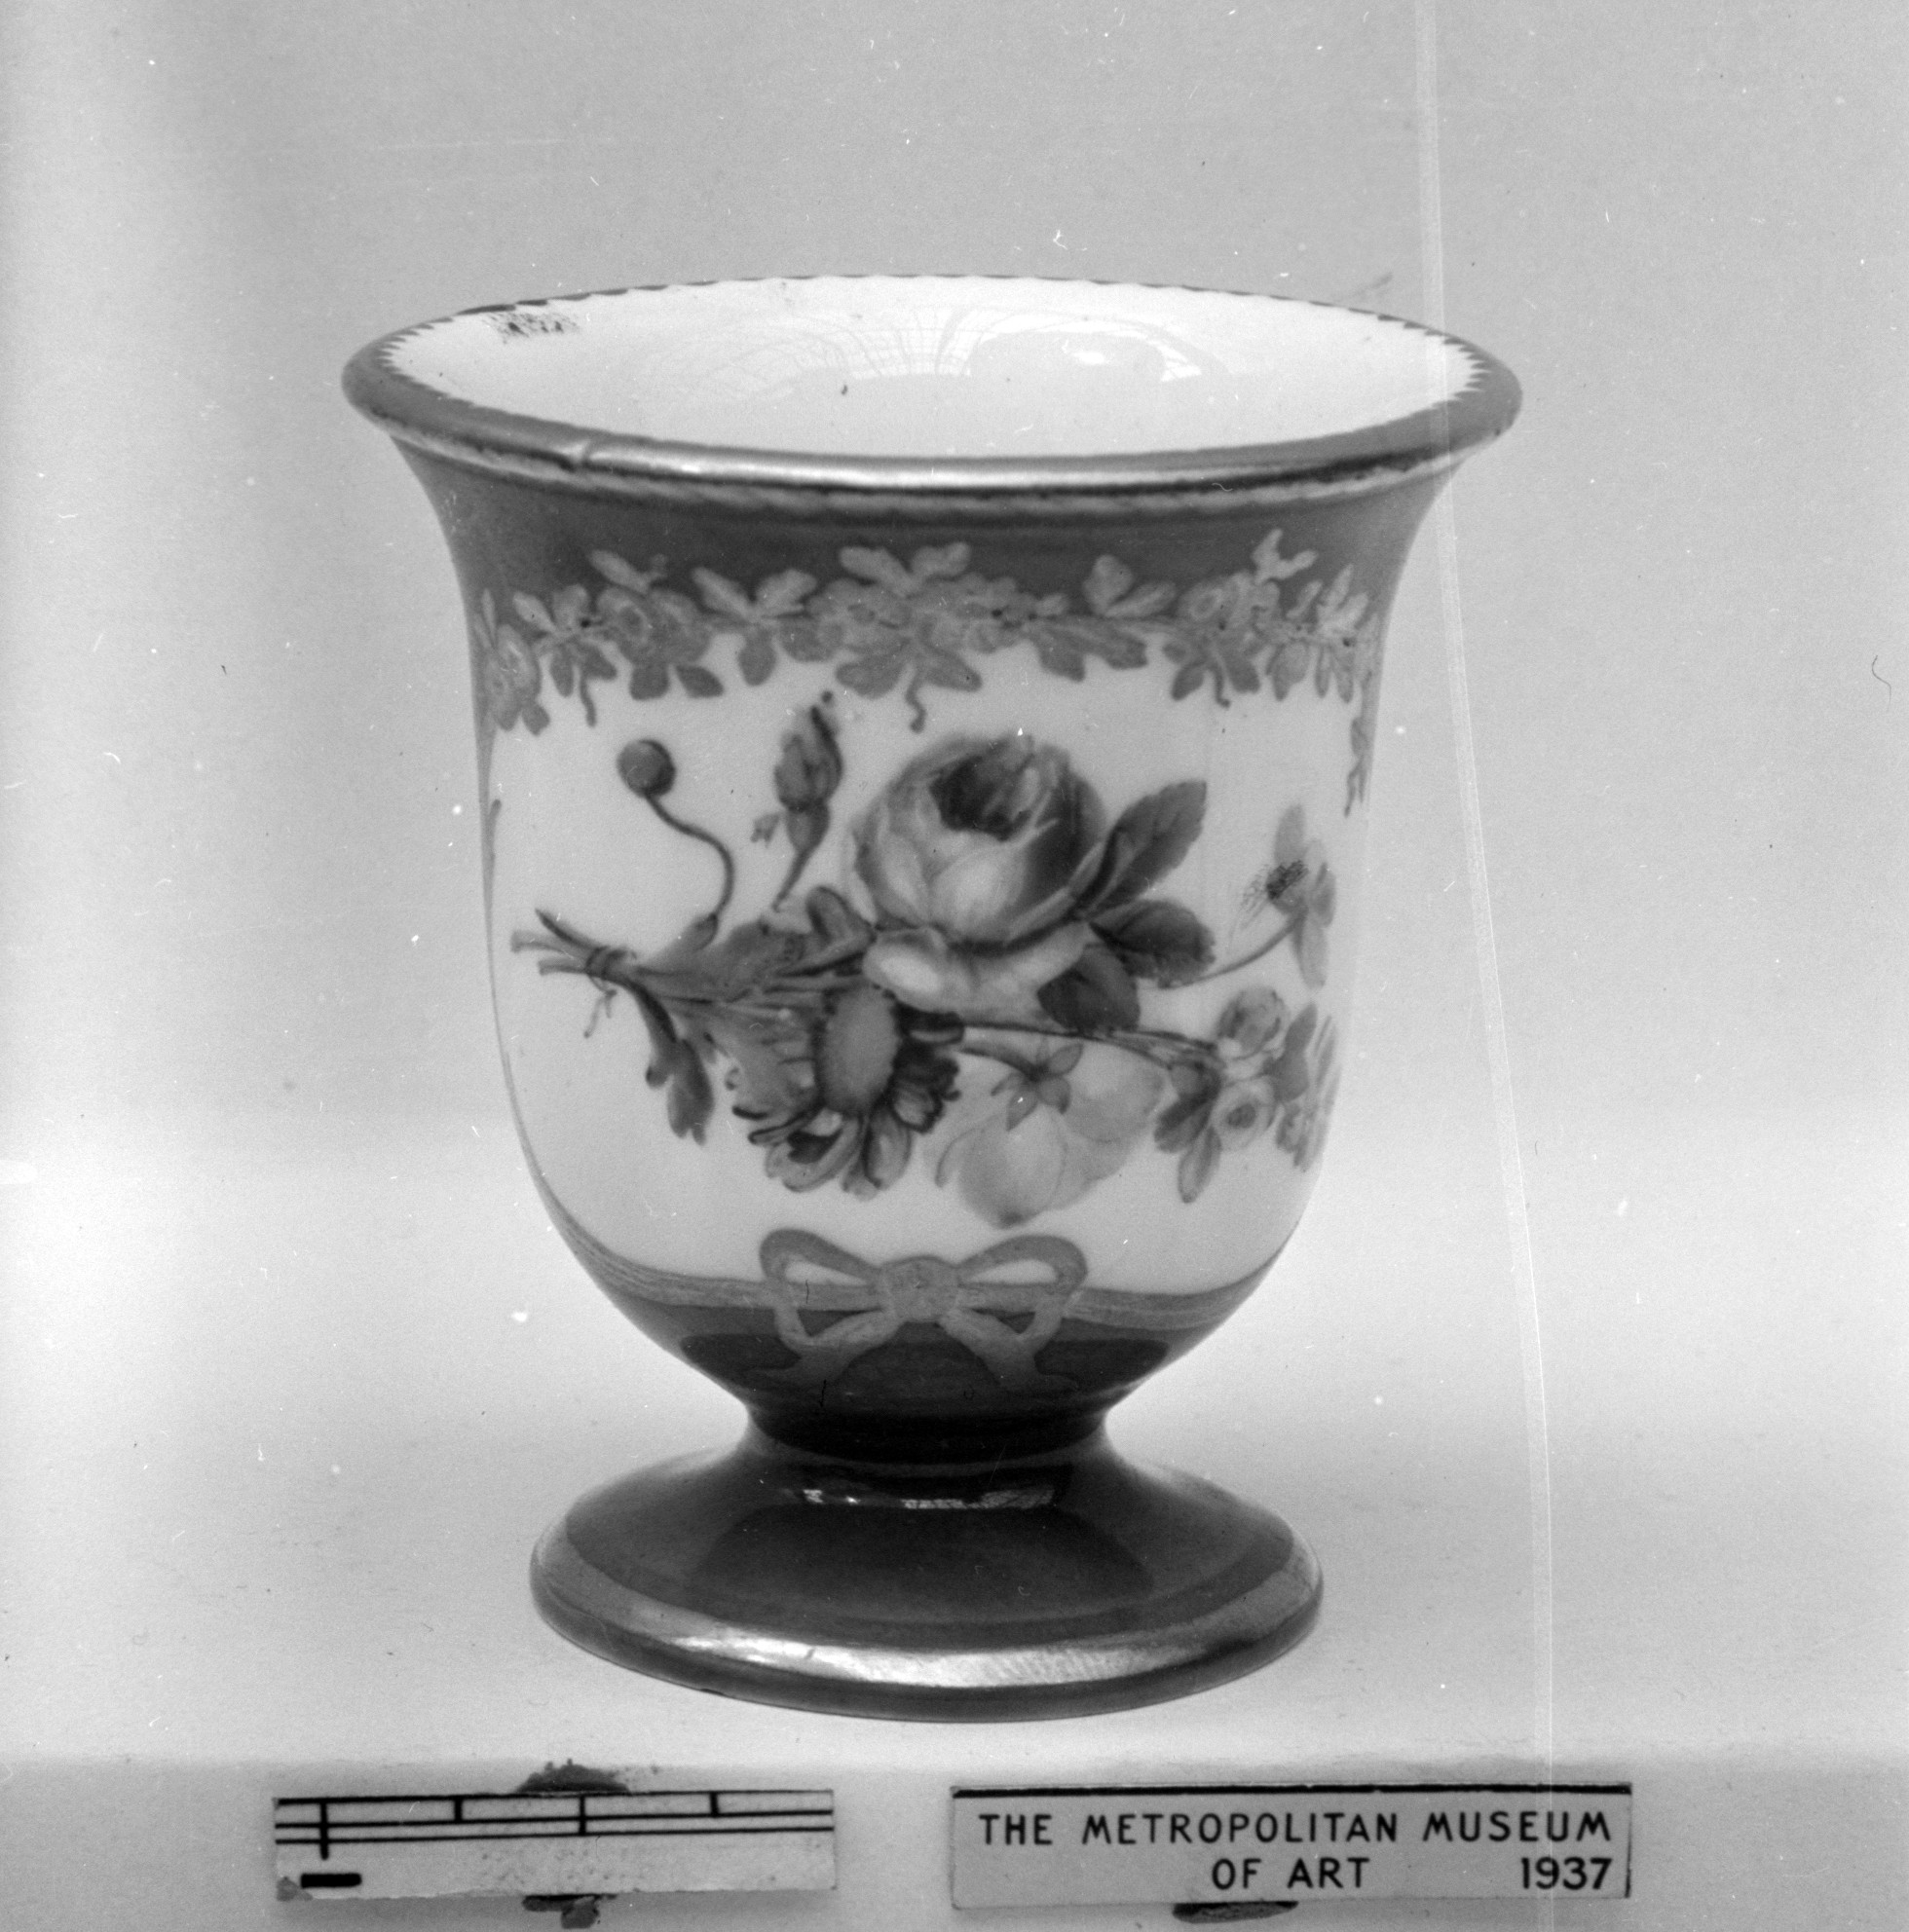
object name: ice cream cup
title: Ice cream cup (Tasse à glace) (part of a service)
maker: sèvres manufactory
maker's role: manufactory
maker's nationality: french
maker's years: 1740-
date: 1775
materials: soft paste porcelain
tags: flowers